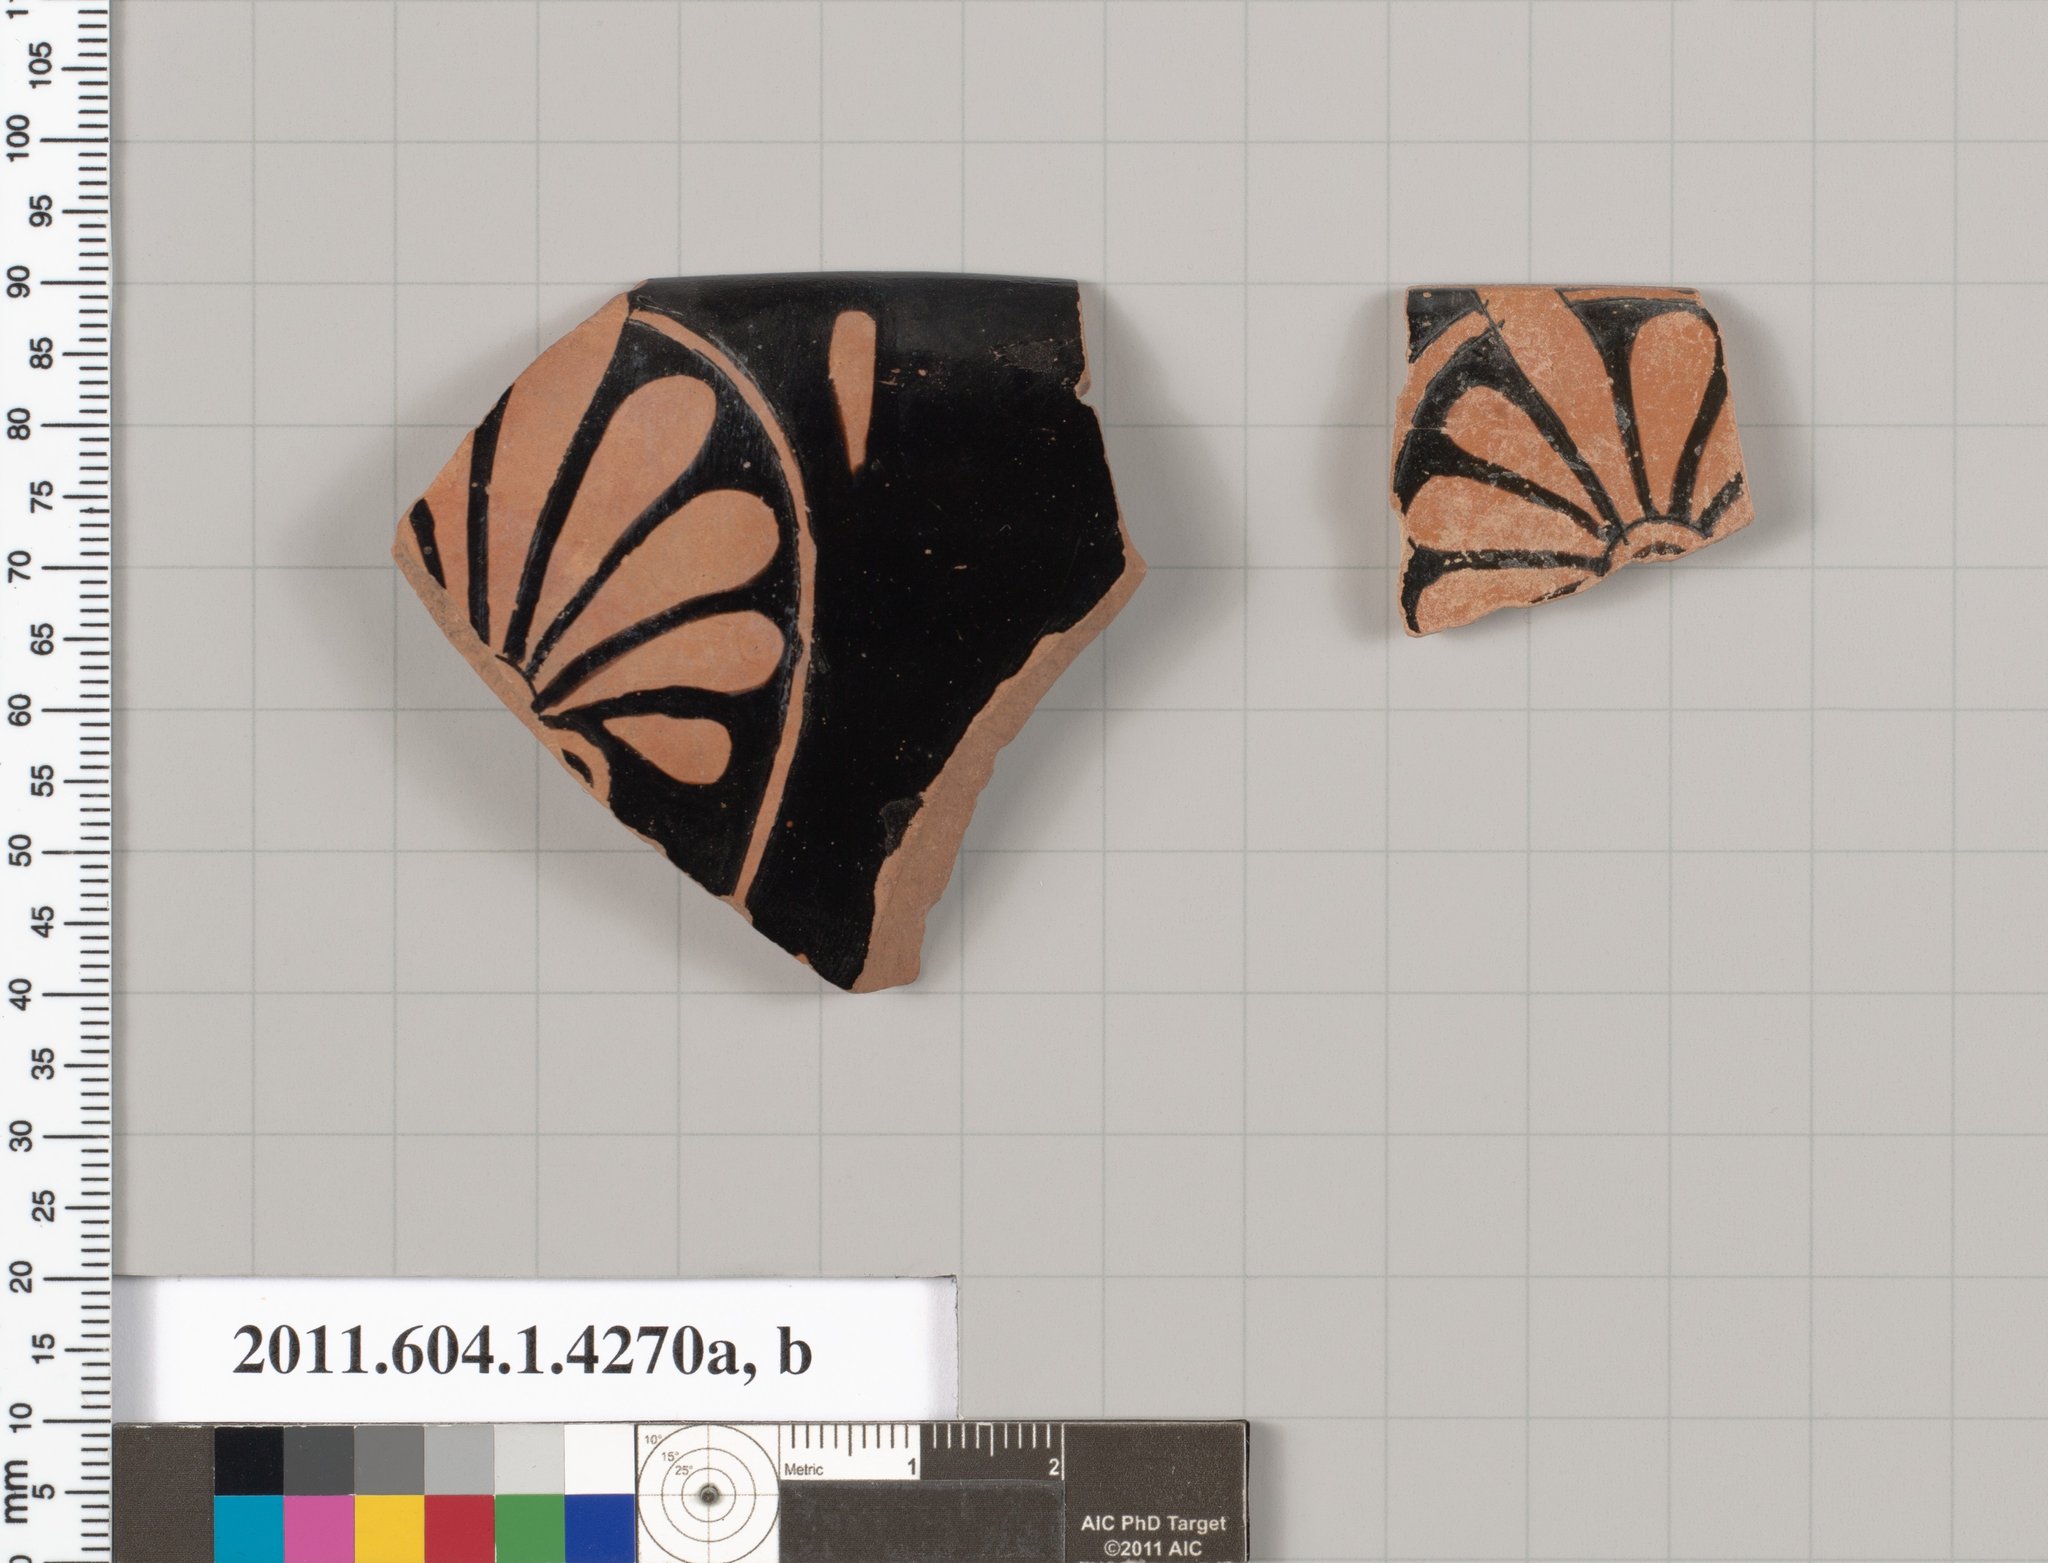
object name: kylix fragment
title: Terracotta rim fragments of kylikes (drinking cups)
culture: greek, attic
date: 500-476 BCE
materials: terracotta